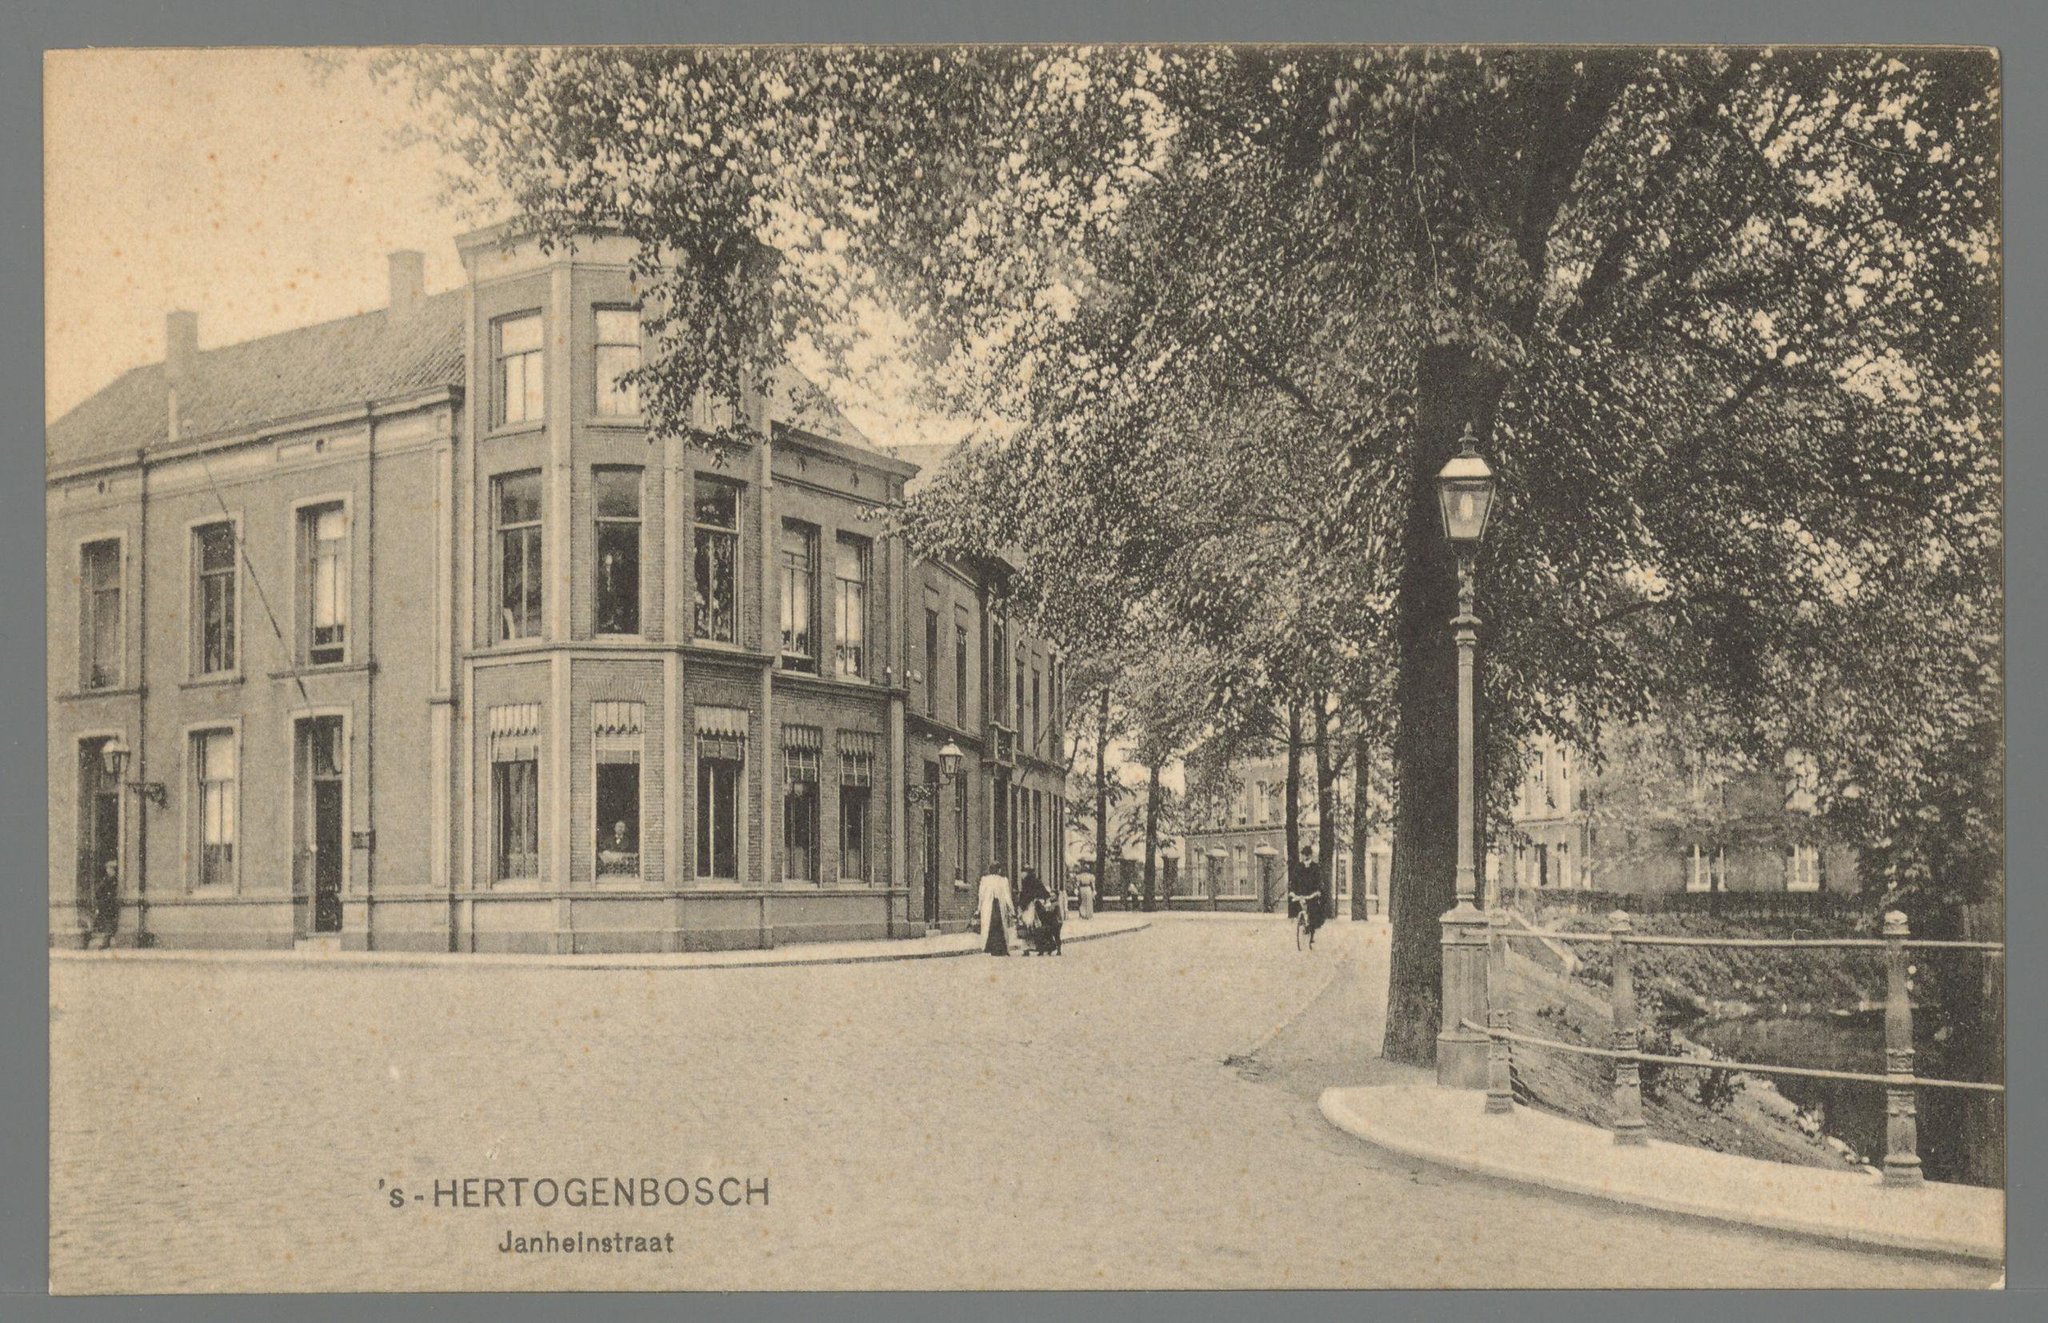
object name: ansichtkaart, prentbriefkaart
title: 's-Hertogenbosch. Janheinstraat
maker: Anonymous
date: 1907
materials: cardboard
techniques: photograph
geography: den bosch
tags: canal, street, den bosch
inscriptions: date